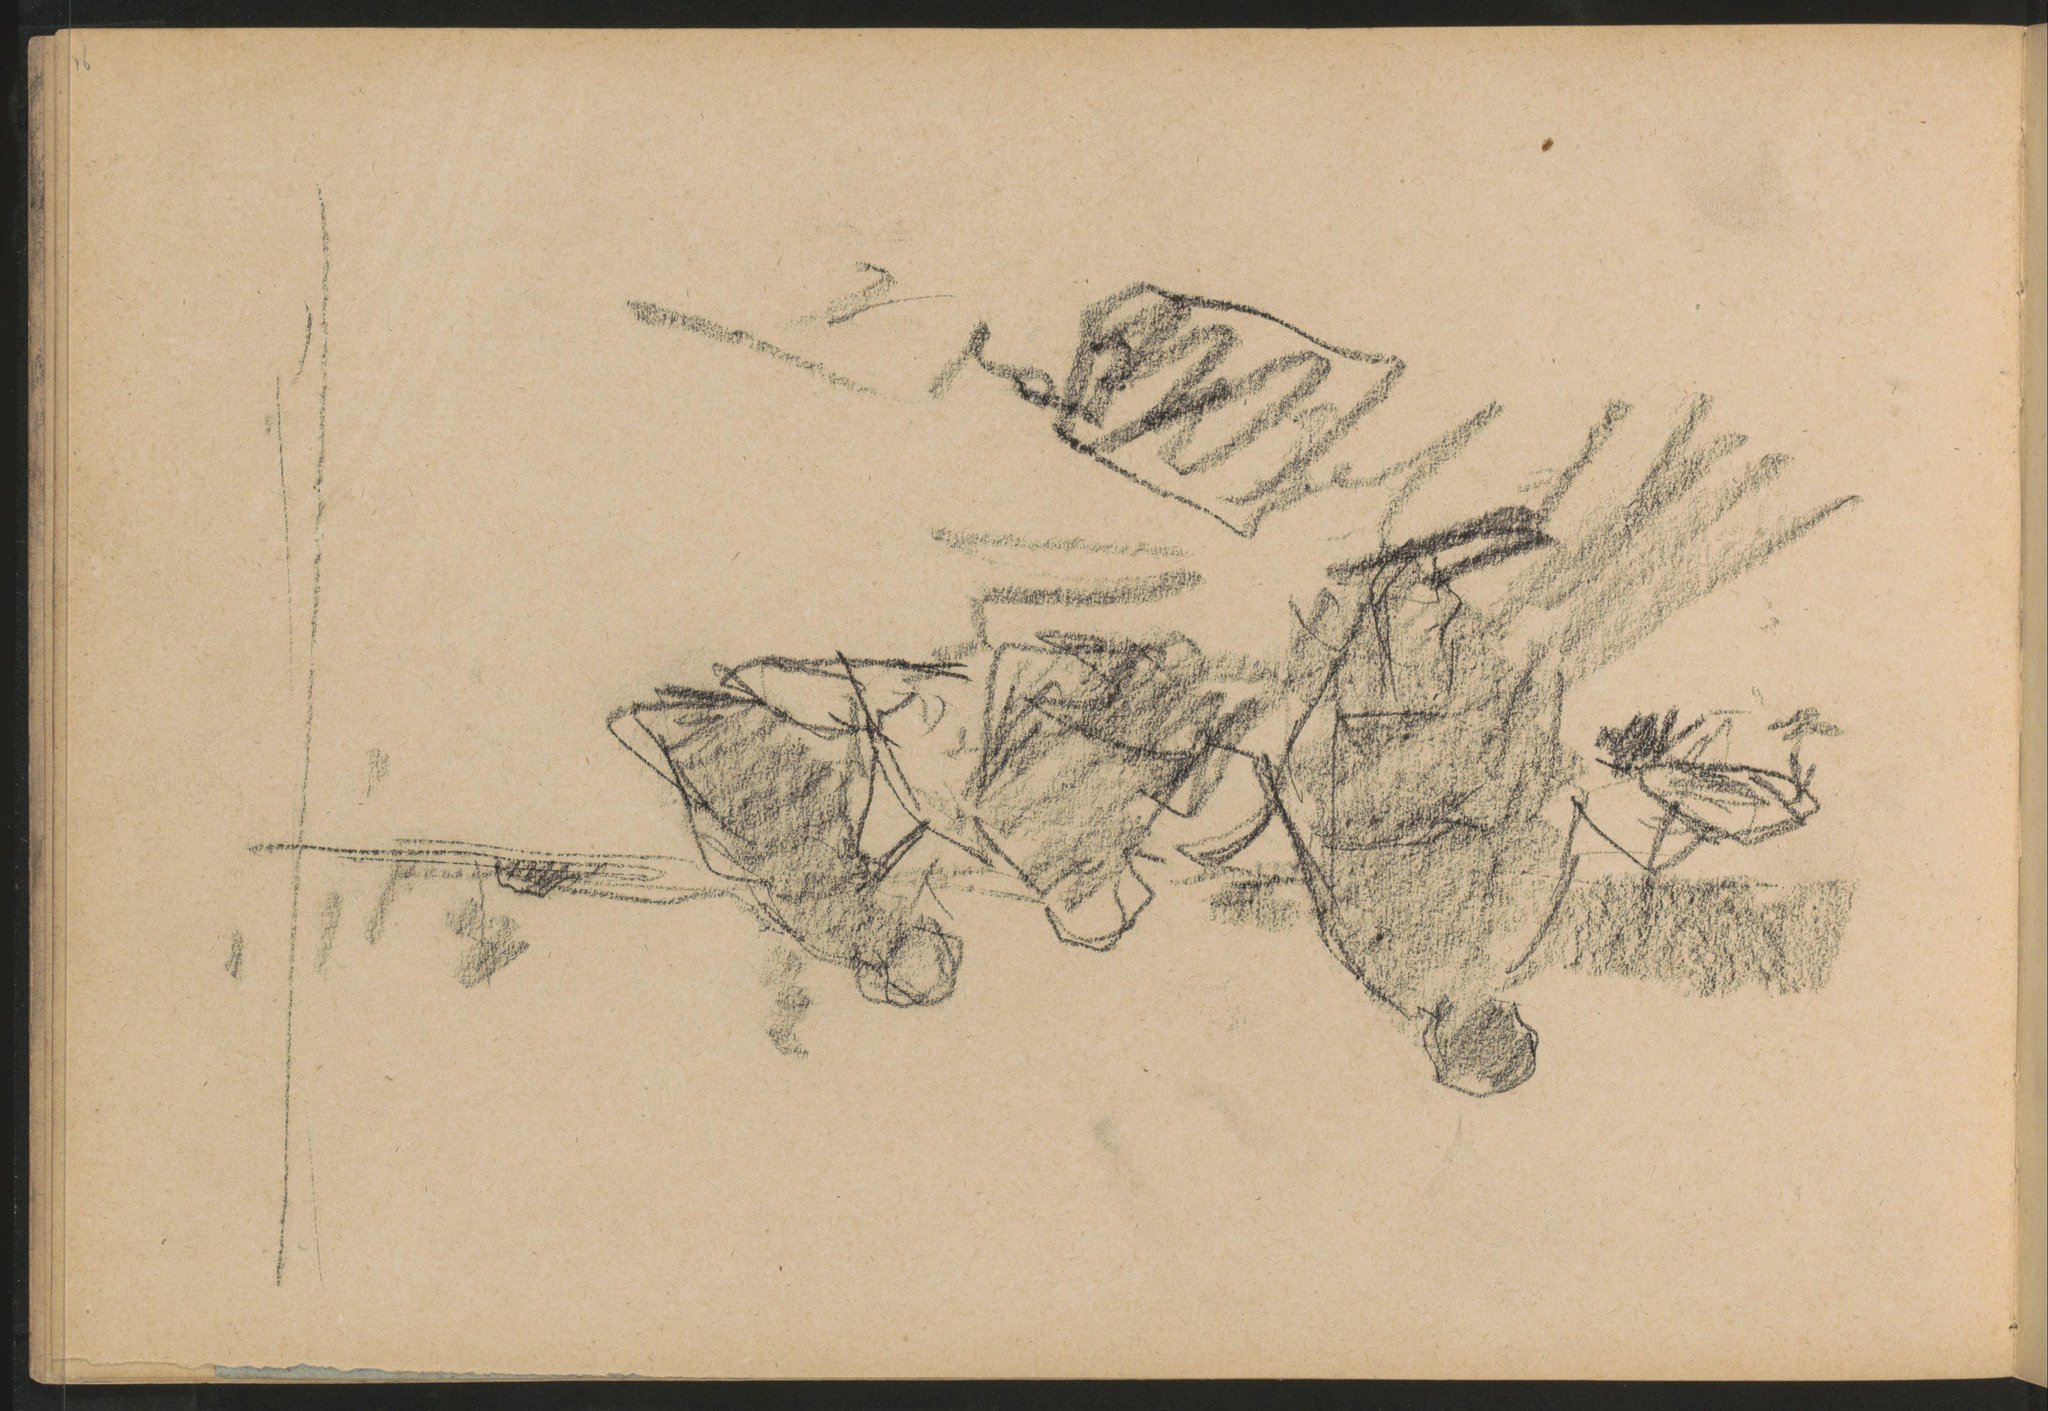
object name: sketchbook leaf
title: Figuren aan het werk op het land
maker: willem witsen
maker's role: draughtsman, painter, print maker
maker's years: 1860-1923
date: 1882-1884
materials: chalk, paper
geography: ewijkshoeve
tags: reaping, picking, mowing ~ harvest, cultivated land (+ landscape with figures, staffage)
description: Mogelijk alleen vrouwen. Ze rooien waarschijnlijk. Pagina 16 uit een schetsboek met 19 bladen.